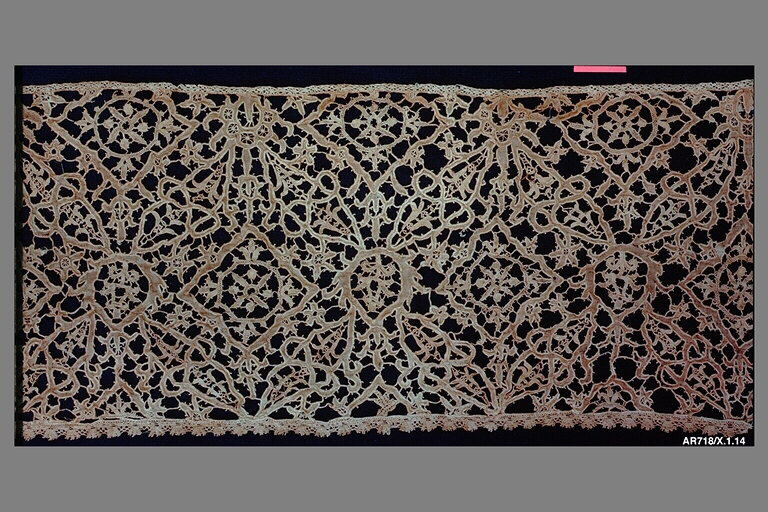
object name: panel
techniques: embroidery